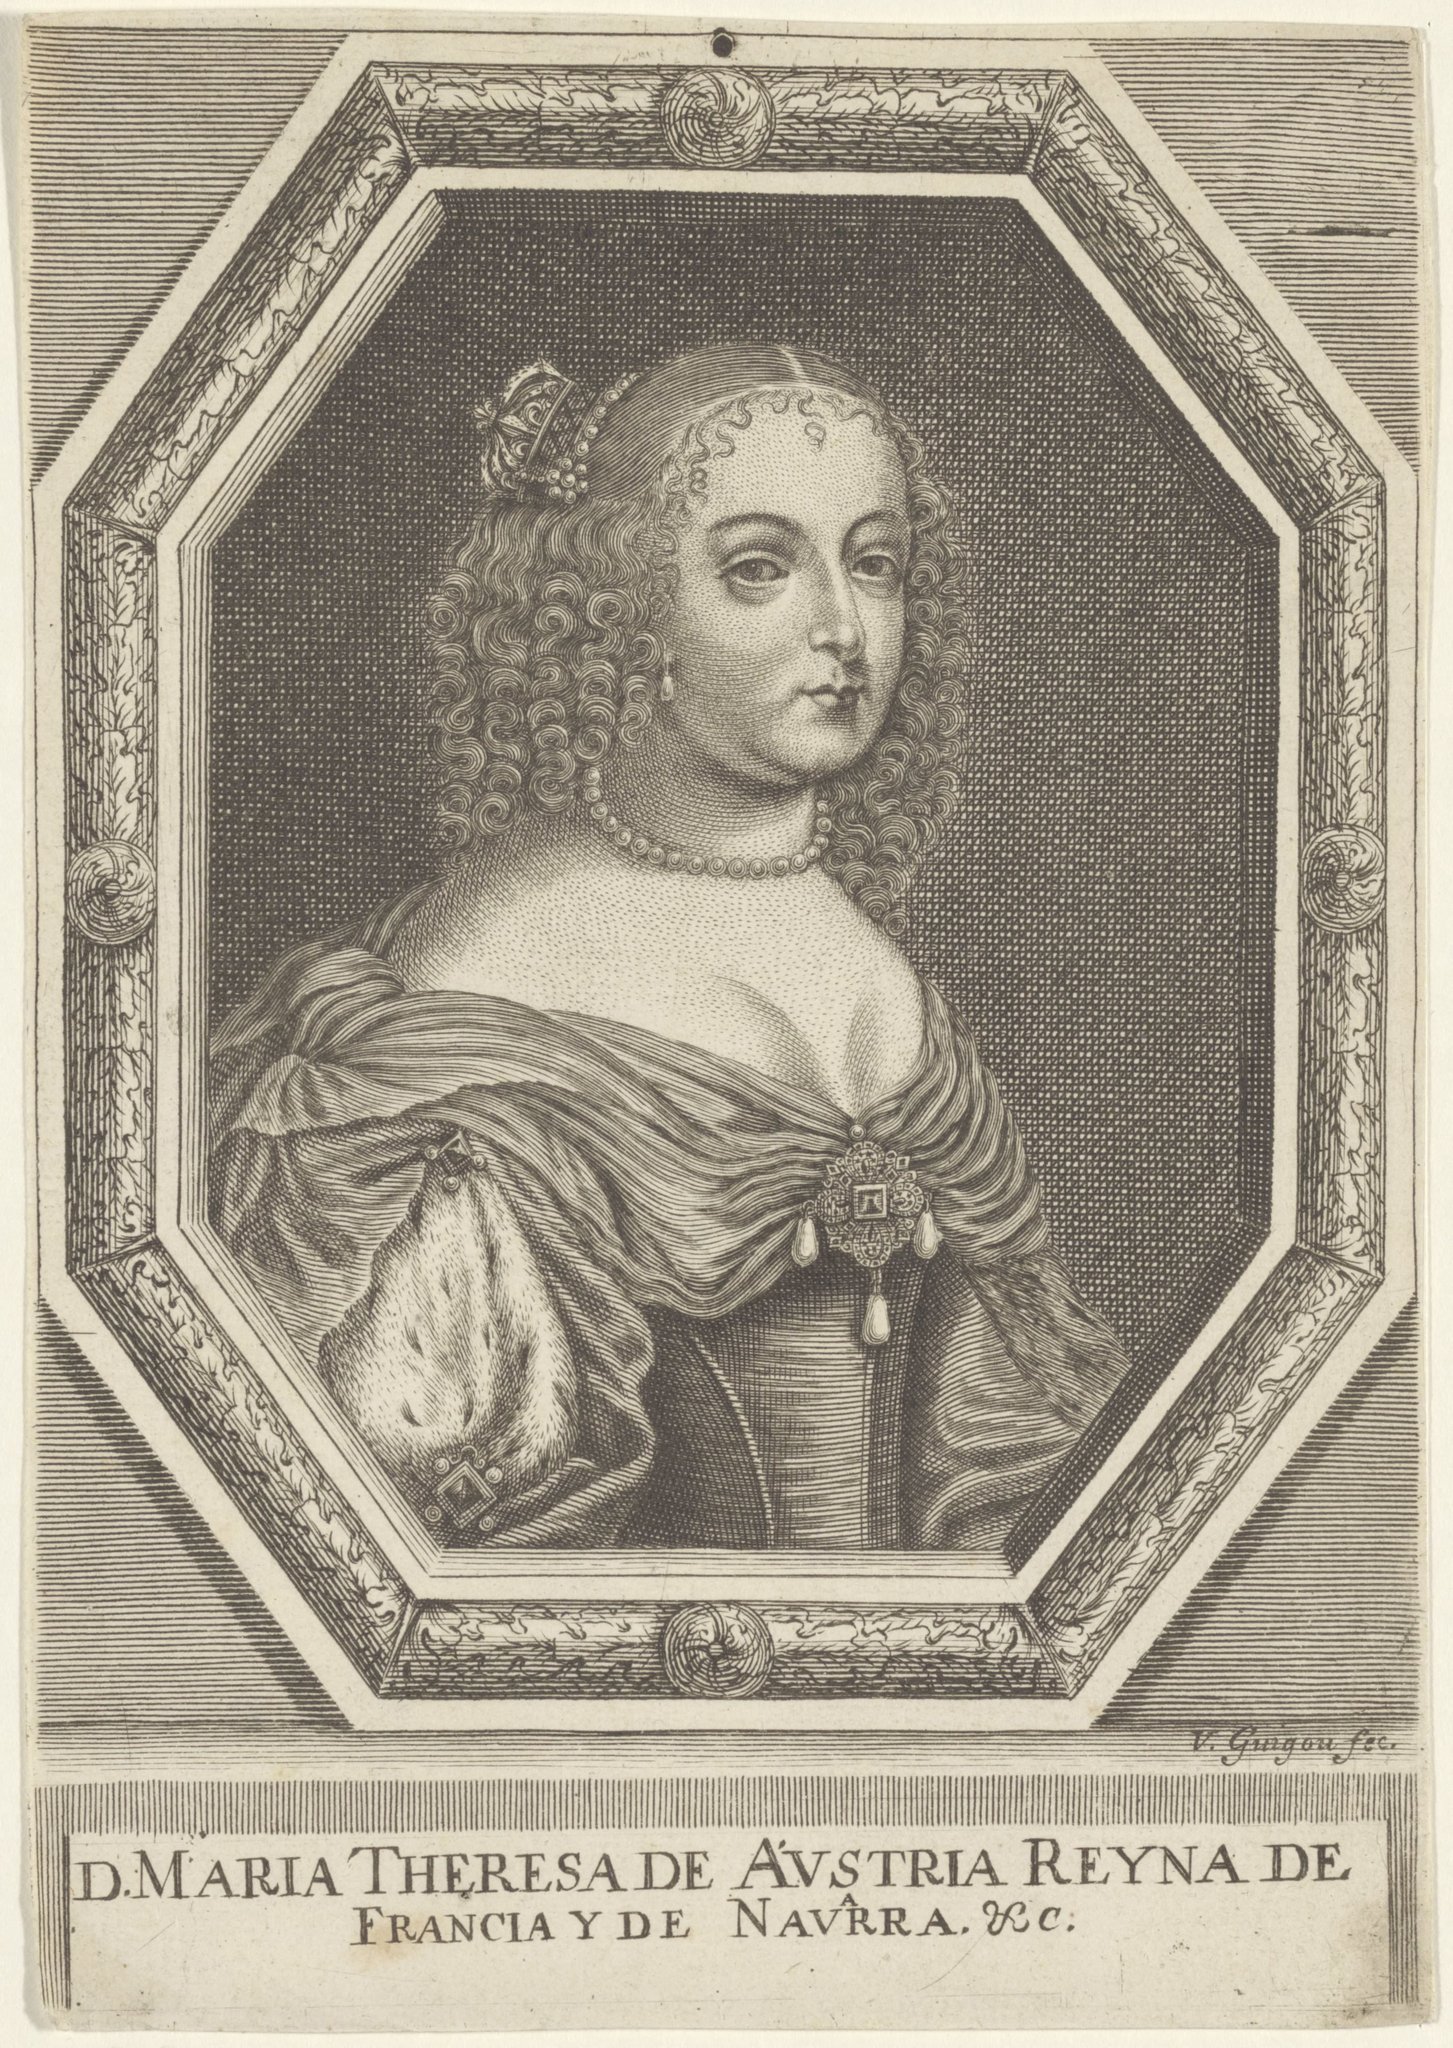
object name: print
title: Portret van Maria Theresia van Oostenrijk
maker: v. guigou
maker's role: print maker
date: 1600-1699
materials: paper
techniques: engraving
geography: italy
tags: vienna, maria theresia (rooms-duits keizerin), historical persons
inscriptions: collector's mark: Lugt 2228